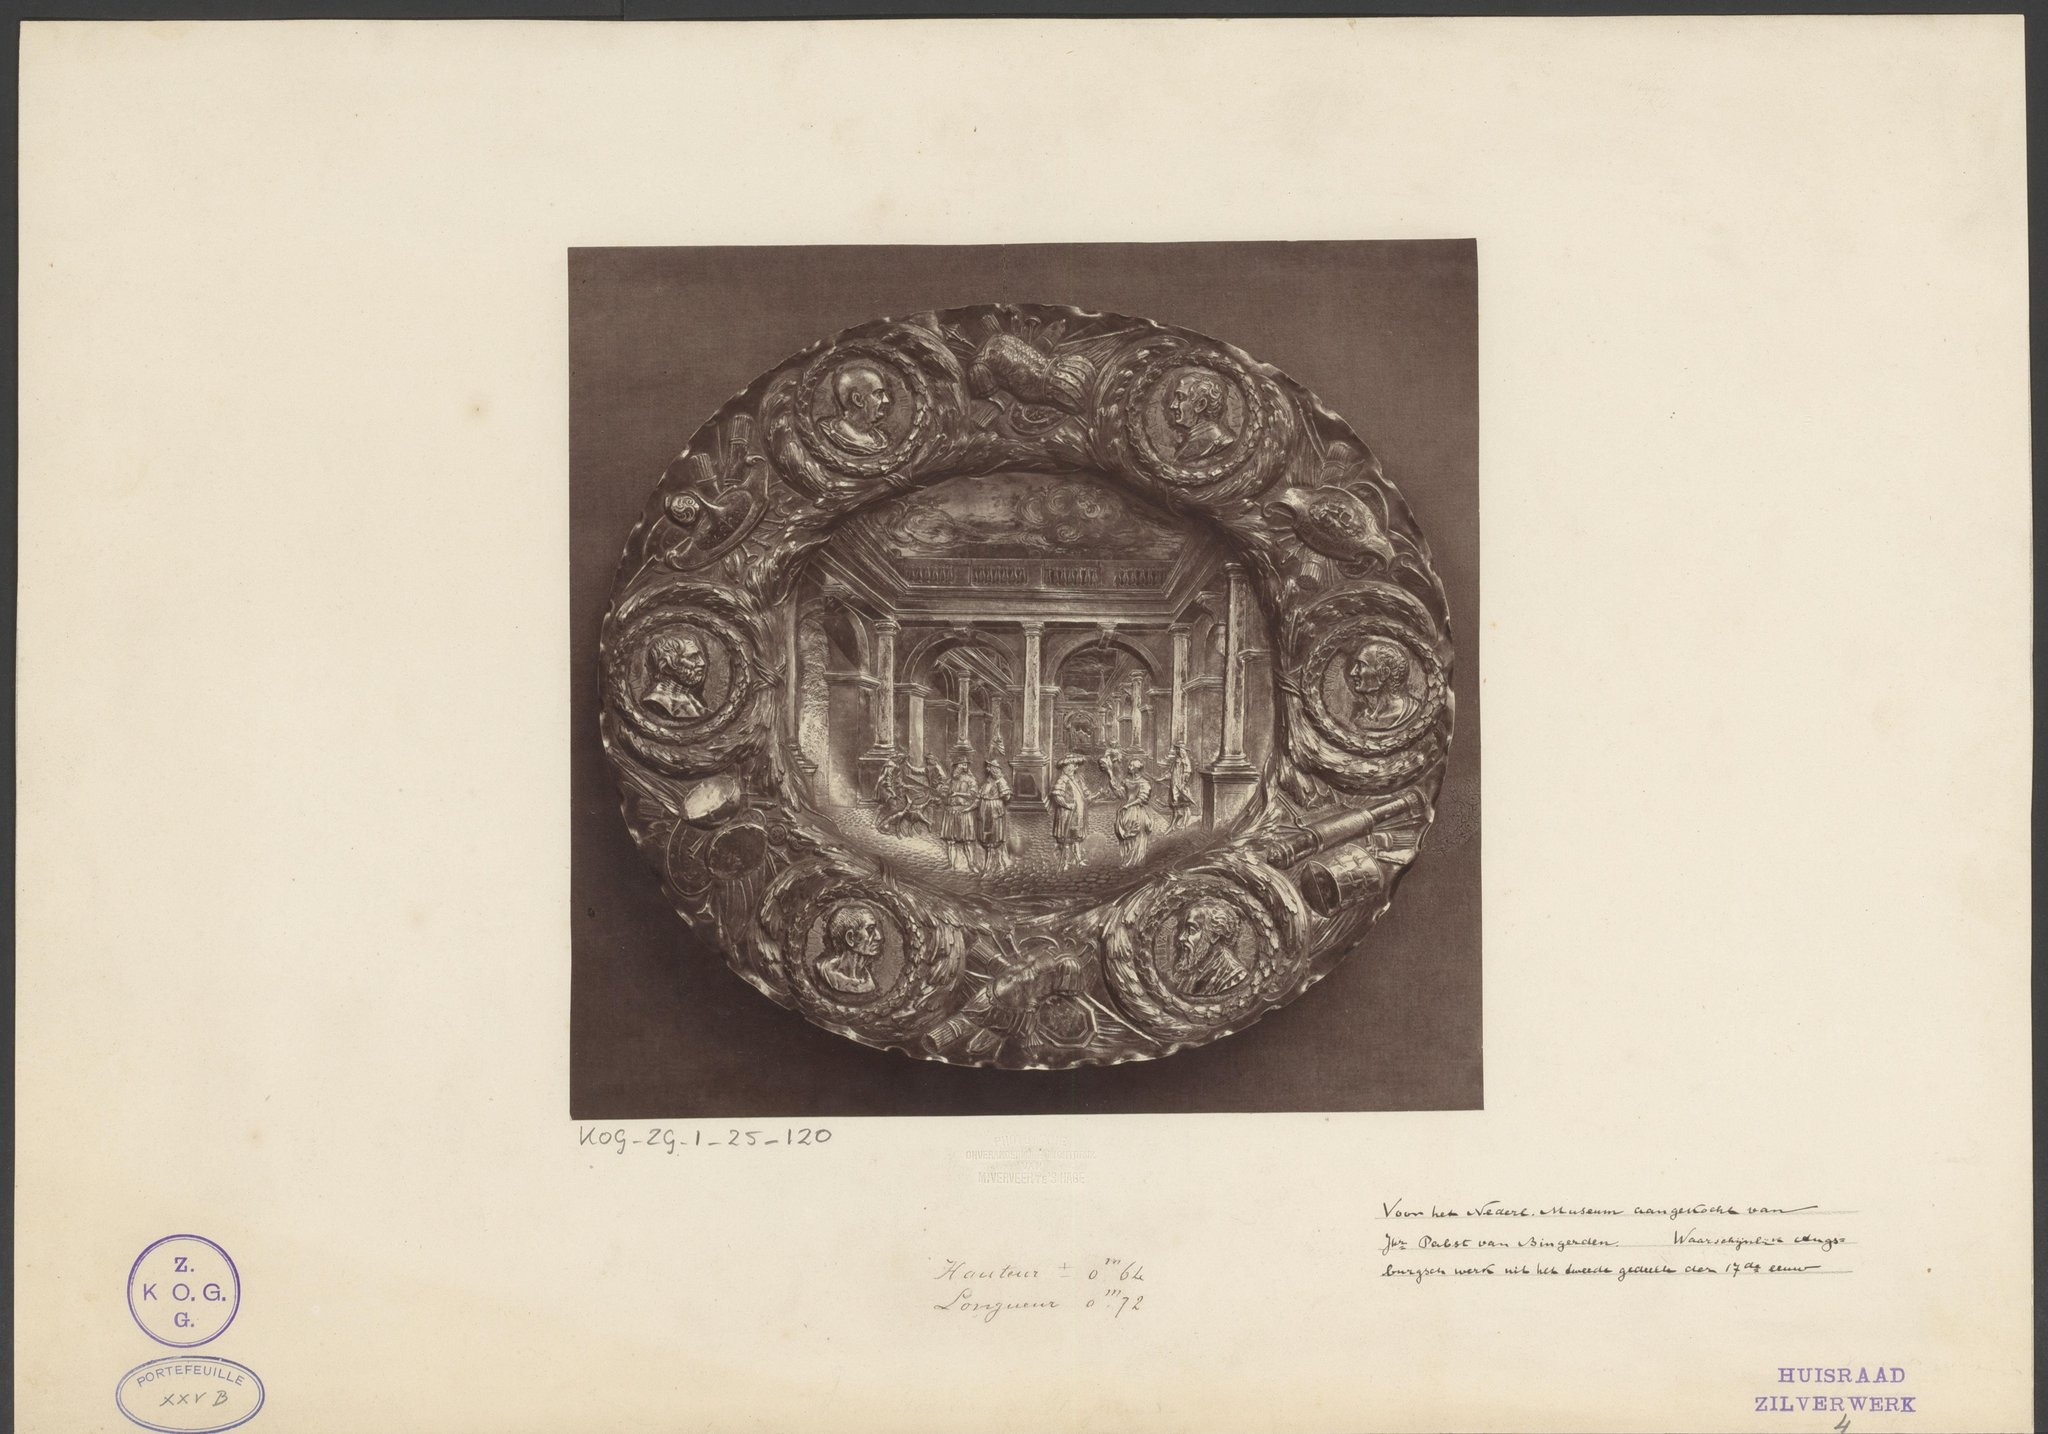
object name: photograph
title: Gipsen afgietsel van een zilveren schaal met portretten van filosofen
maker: maurits verveer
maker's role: painter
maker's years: 1817-1903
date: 1857-1903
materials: paper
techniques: carbon print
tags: marcus tullius cicero, lucius annaeus seneca, dish, plate, saucer, container of precious metal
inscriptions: stamp, collector's mark: Lugt 1641, stamp, check stamp: ‘Phototypie onveranderlijk lichtdruk van M. Verveer te 's Hage’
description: Zilveren schaal met diverse portretten van filosofen, waaronder Lucius Annaeus Seneca en Marcus Tullius Cicero. In het middel staan verschillende mensen in een ruimte met diverse bogen. Onderwerpsrubrieken binnen de Atlas Zeden en Gewoonten: Zeden en Gewoonten in Engeren Zin, De Woning, Huisraad, Zilverwerk.